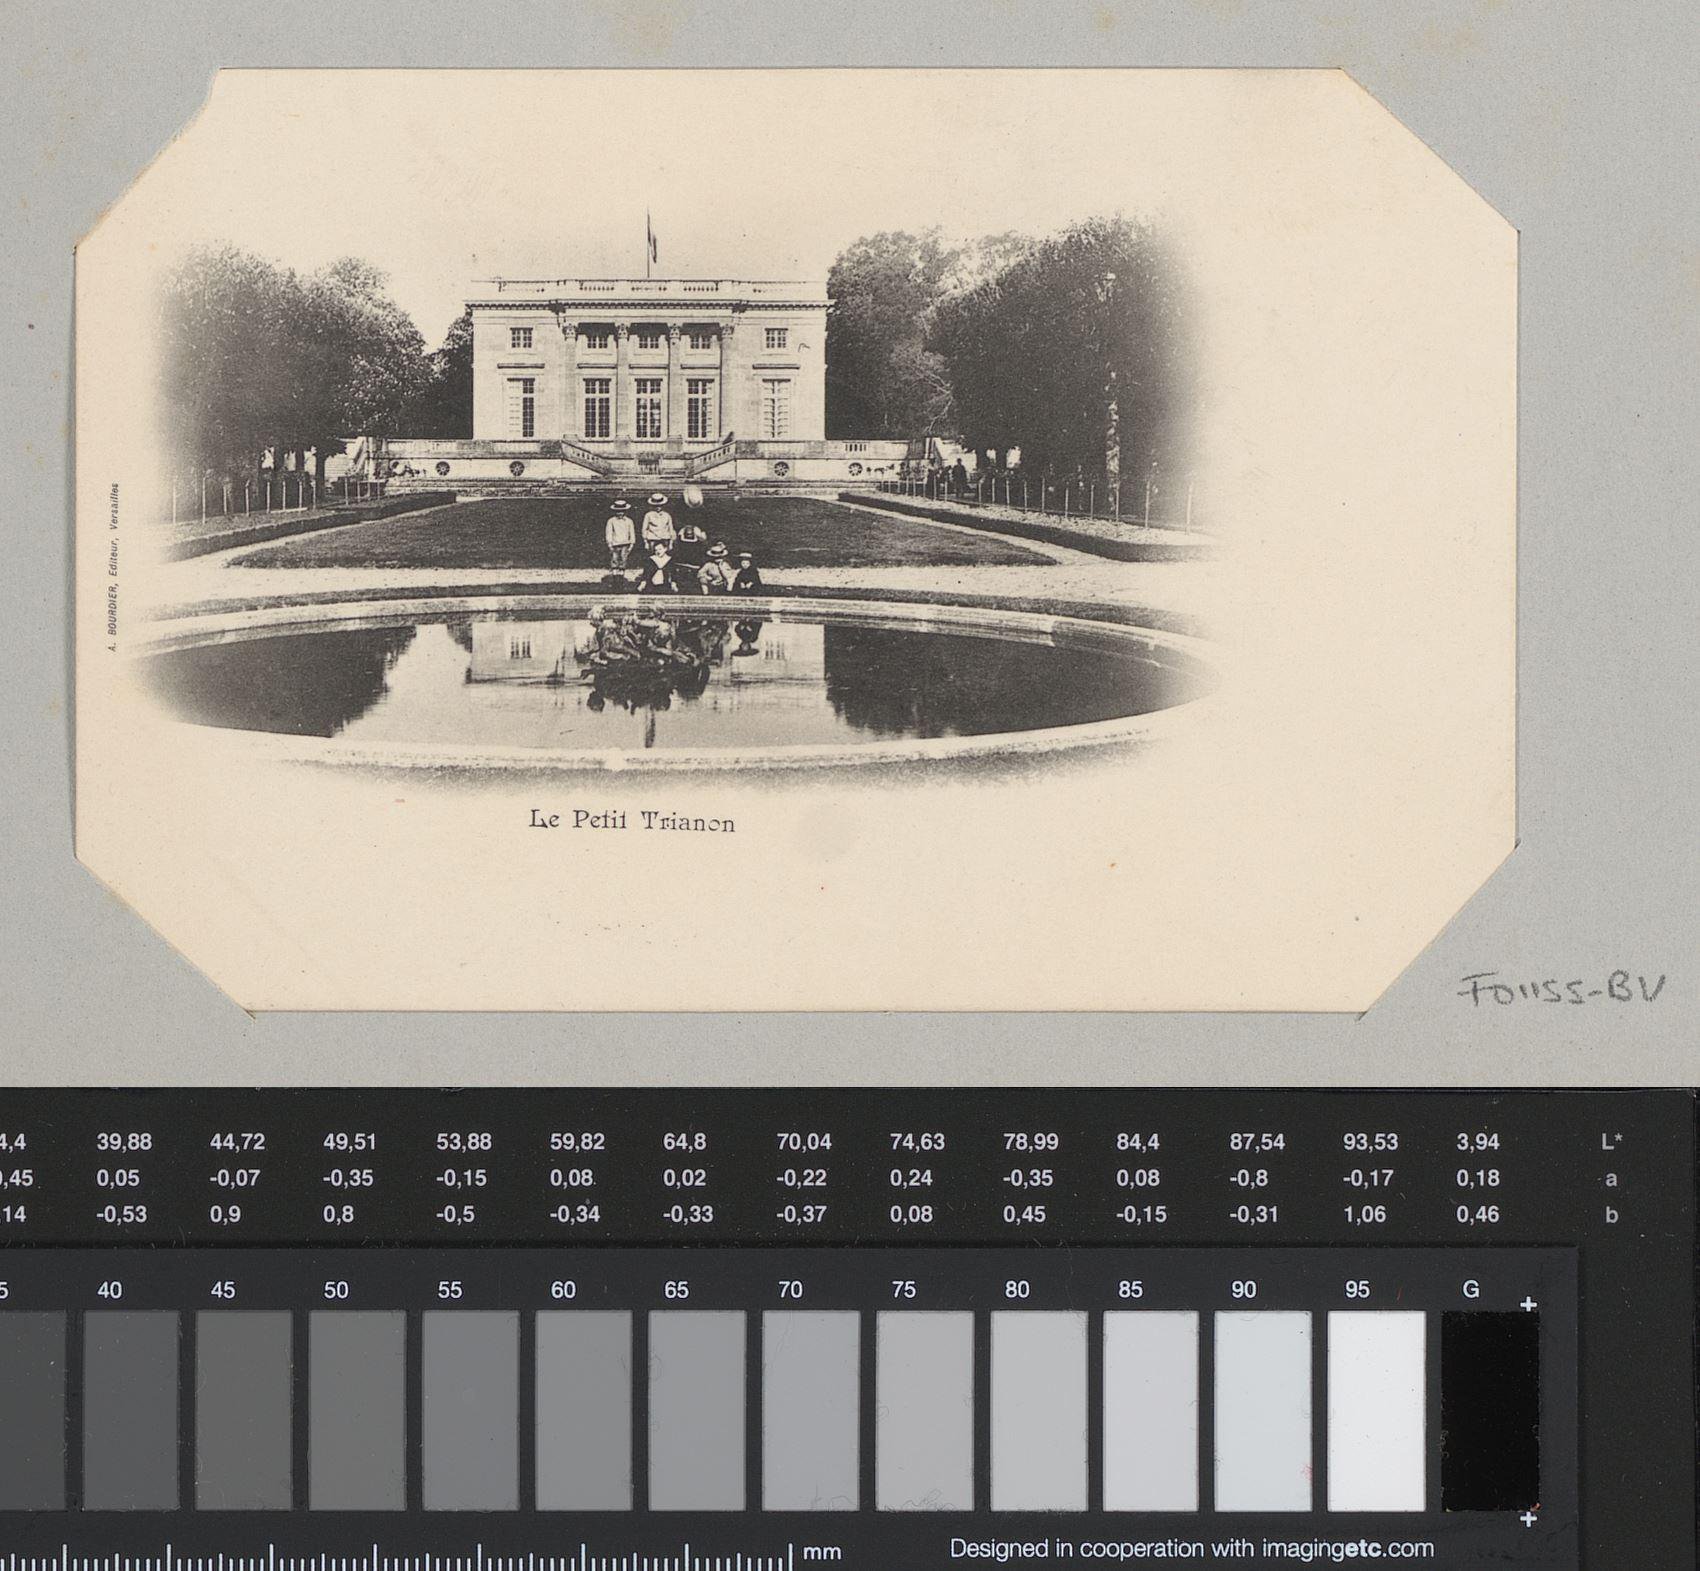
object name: album leaf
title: Gezicht op het Klein Trianon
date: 1890-1898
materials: cardboard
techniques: photograph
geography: versailles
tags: castle, french or architectonic garden; formal garden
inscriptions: inscription: ‘A. Bourier, Edituer, Versailles/ Le Petit Trianon’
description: Deze prent maakt deel uit van een album.